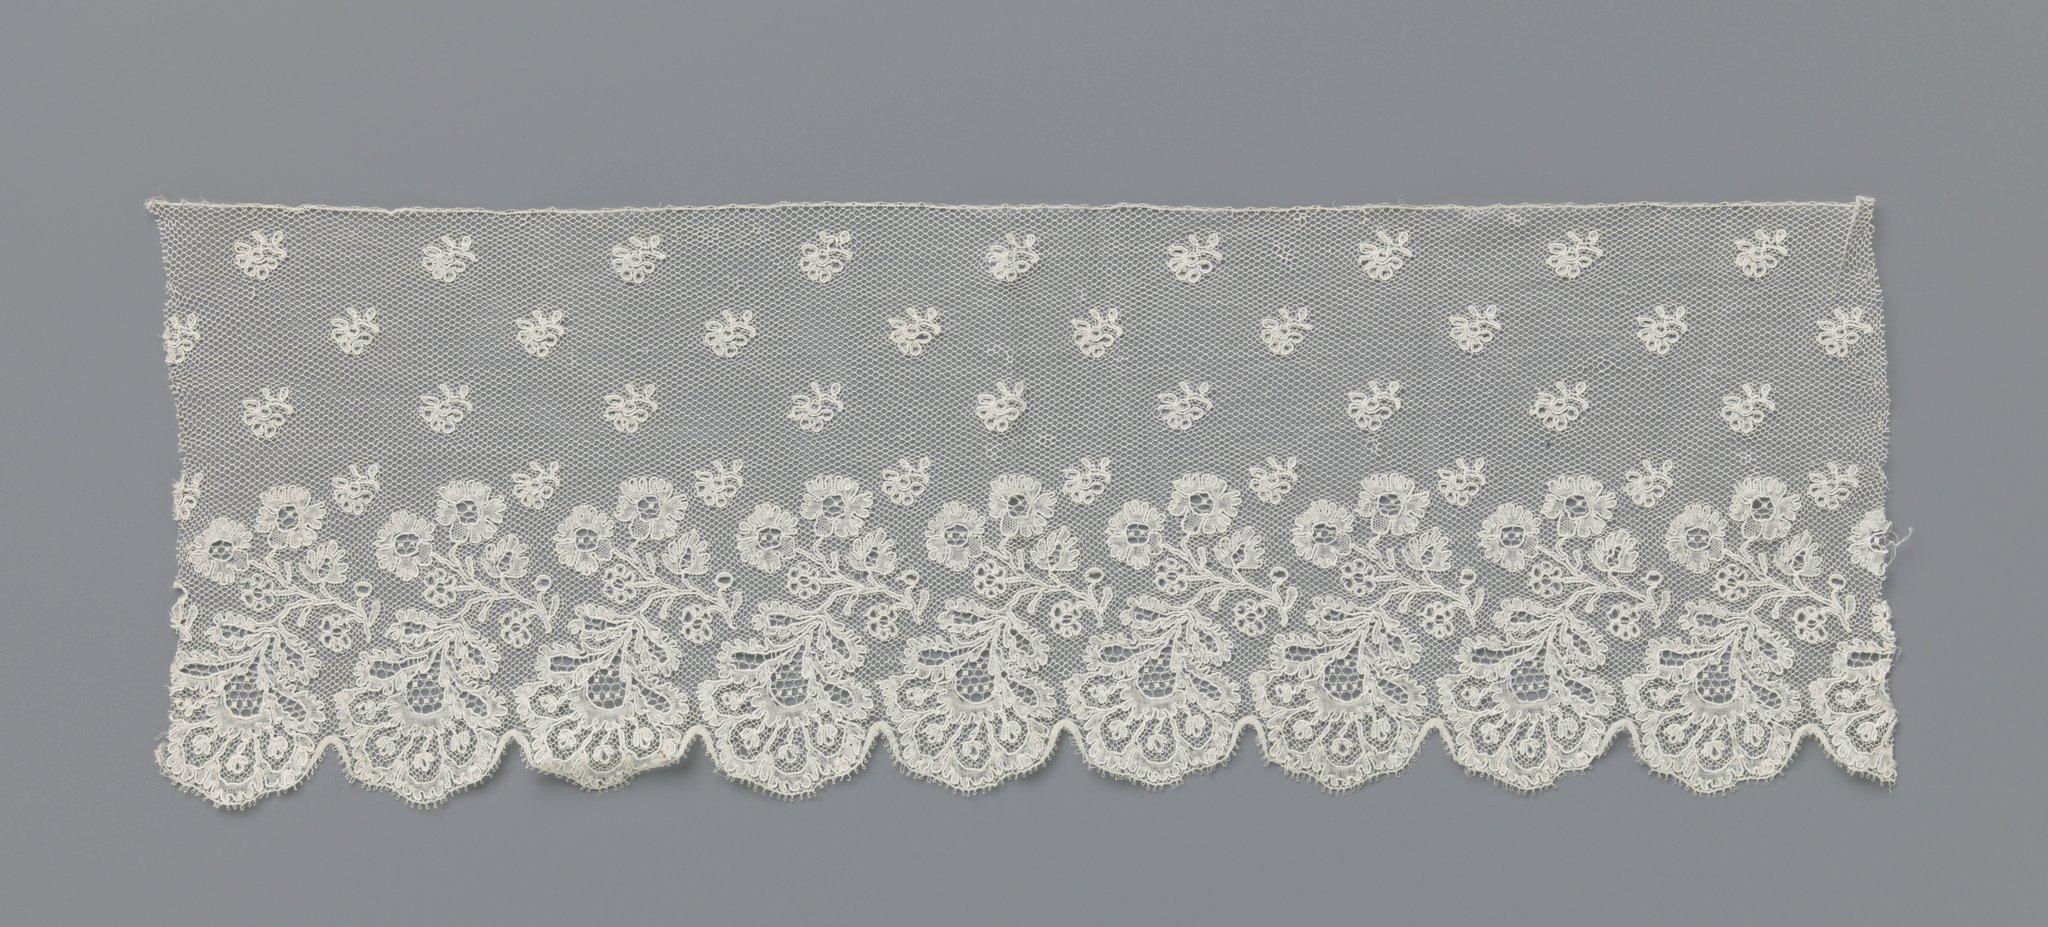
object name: strip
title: Strook kloskant met hangende bloemen in schulpenrand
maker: Anonymous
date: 1830-1840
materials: linen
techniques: lace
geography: mechelen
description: Strook naturelkleurige kloskant: Mechelse kant. Onder een strooipatroon van bloempjes staat een rij eenzijdig gerichte bloemtakjes, met daaraan vijf kleine bloemen en één grote bloem. De grootste bloemen hangen naar beneden en vormen de schulpenrand lang de onderzijde van de strook. De motieven zijn met elkaar verbonden door een traliegrond, een Mechelse grond. De motieven zijn gemaakt in linnenslag en om de motieven lopen dikkere contourdraden. Er zijn twee soorten siergronden gebruikt en versieringen in vierkante vormslag. De bovenzijde en één zijkant zijn afgewerkt met een rechte rand, de andere zijkant is niet afgewerkt.De bovenzijde en één zijkant zijn afgewerkt met een rechte rand, de andere zijkant is niet afgewerkt.